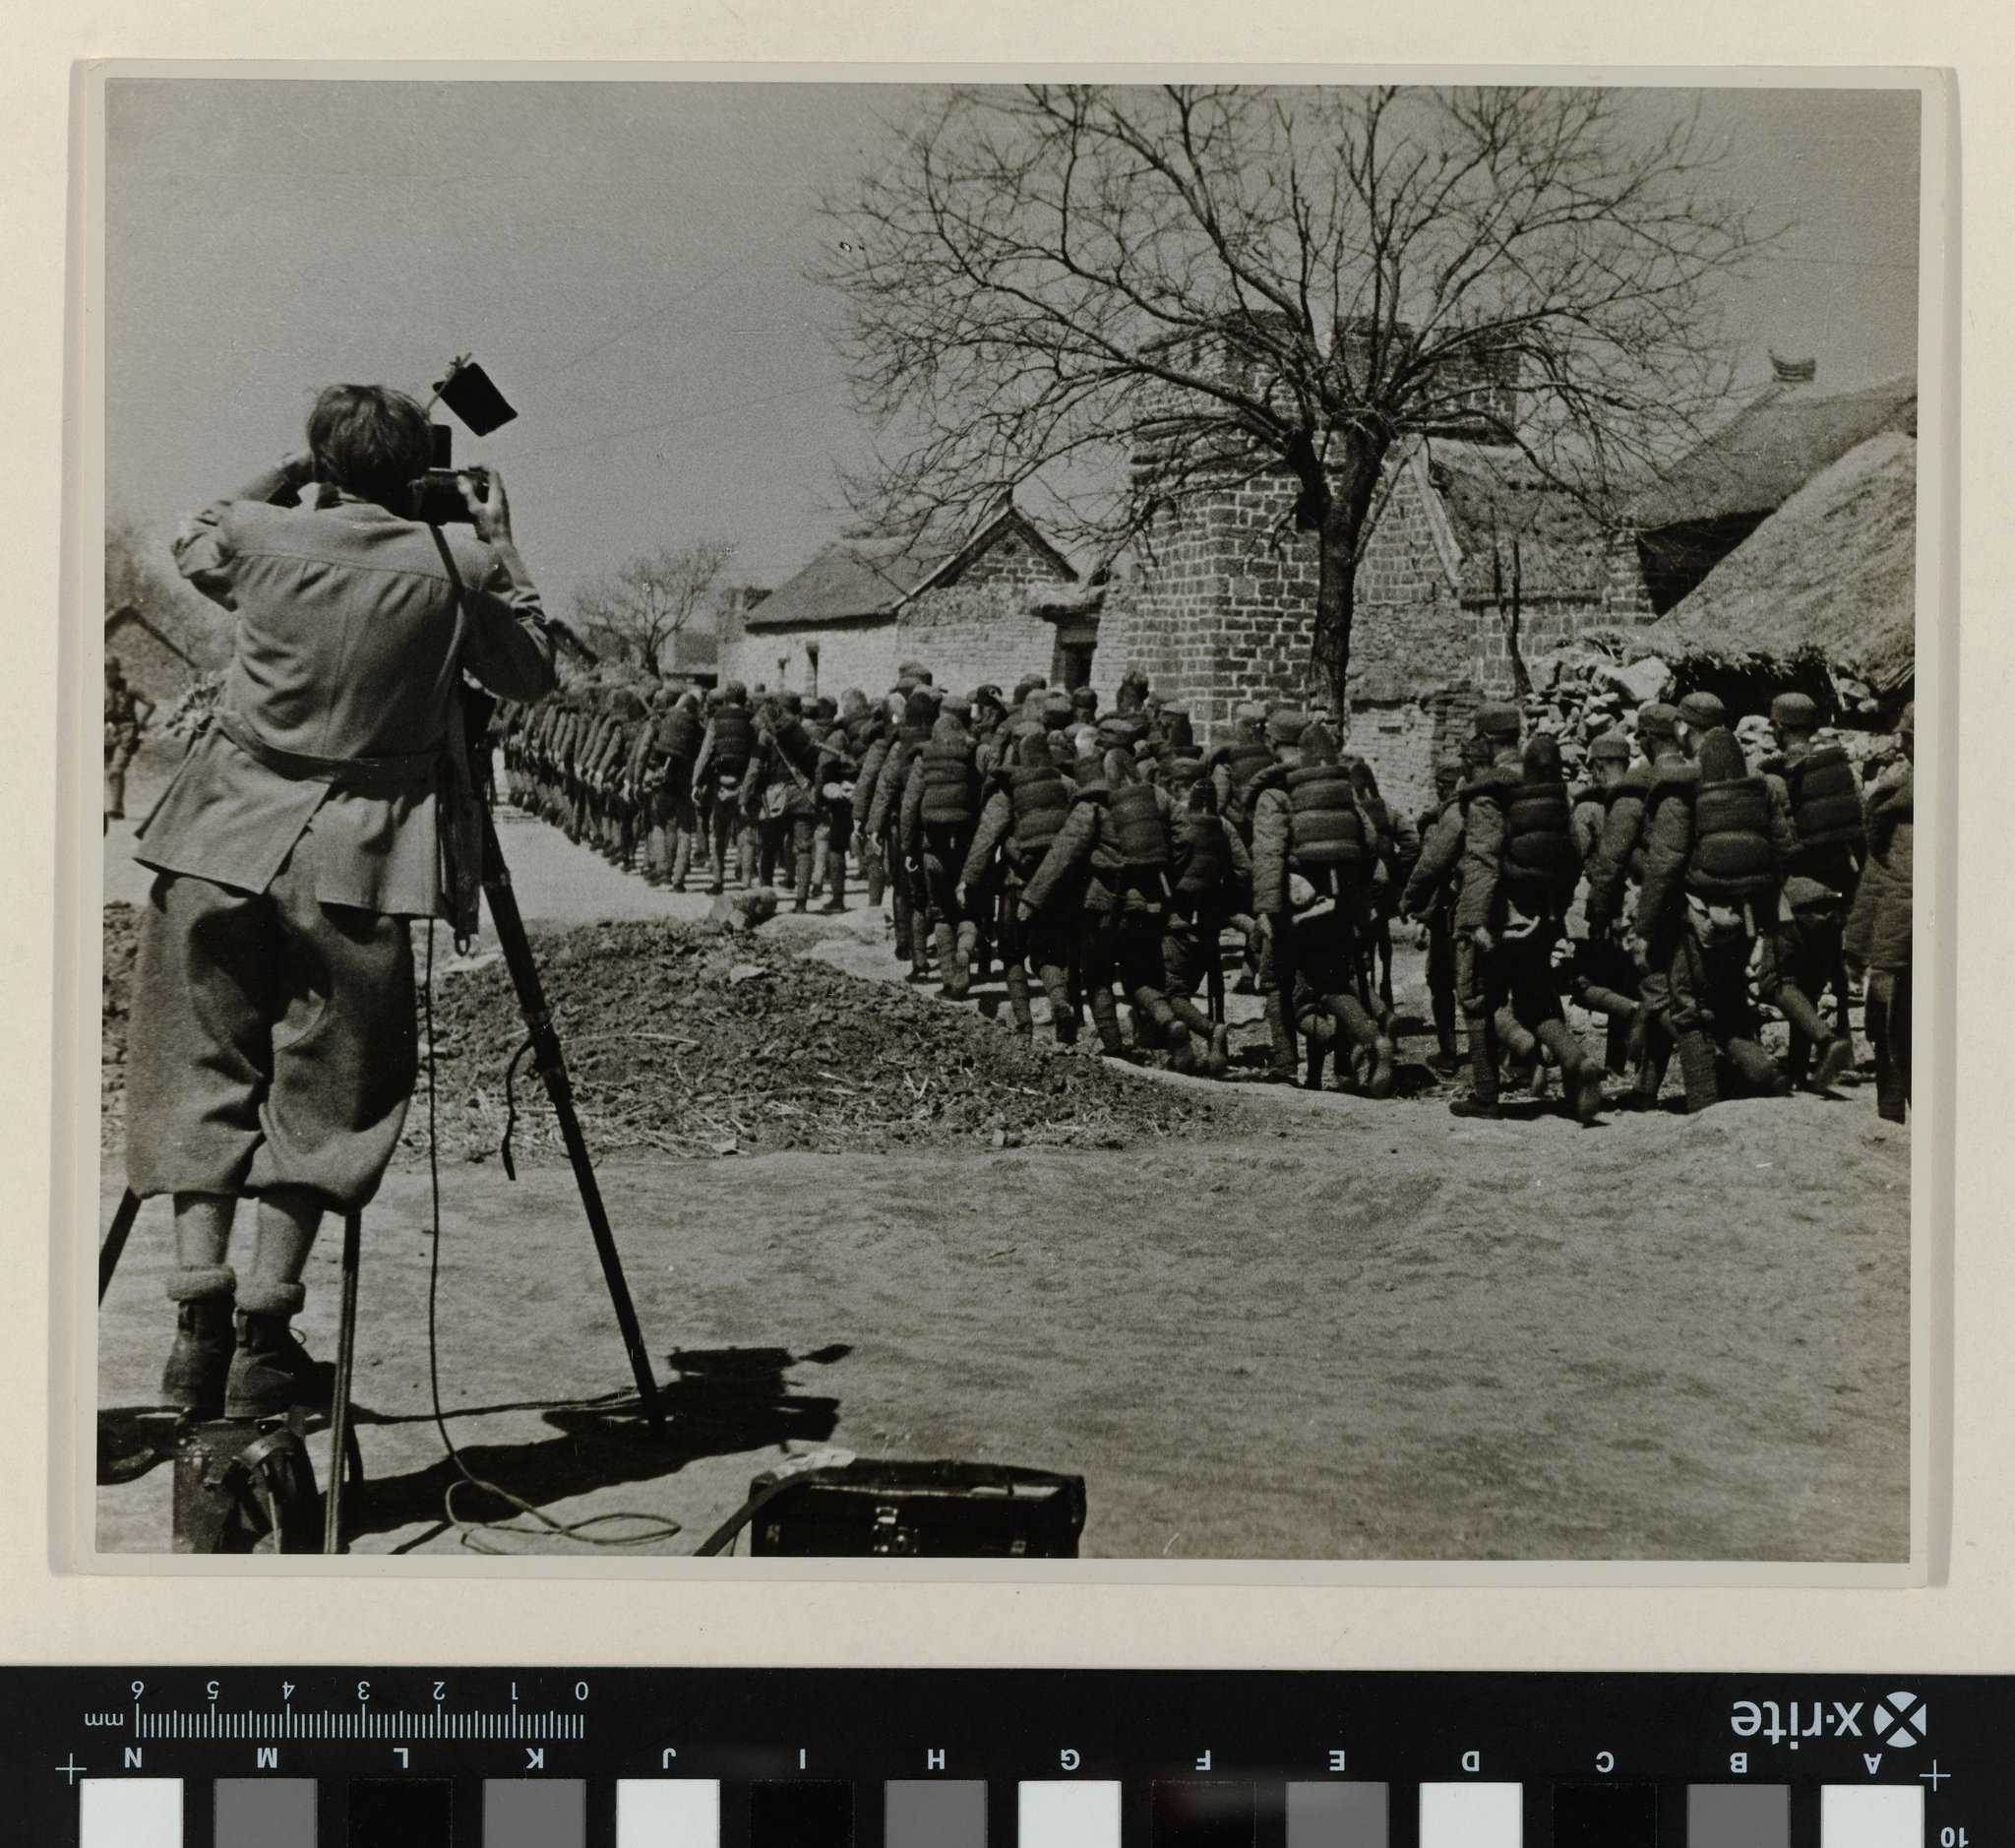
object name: photograph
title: John Fernhout filmt marcherende soldaten, China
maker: robert capa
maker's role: fotograaf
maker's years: 1913-1954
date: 1938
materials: paper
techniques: gelatin silver print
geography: china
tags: john fernhout, filming, cinematographer at work - cc - out of doors, marching away (troops) (+ company), china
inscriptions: number: ‘11/ 20 x 25’, stamp: ‘E 253’